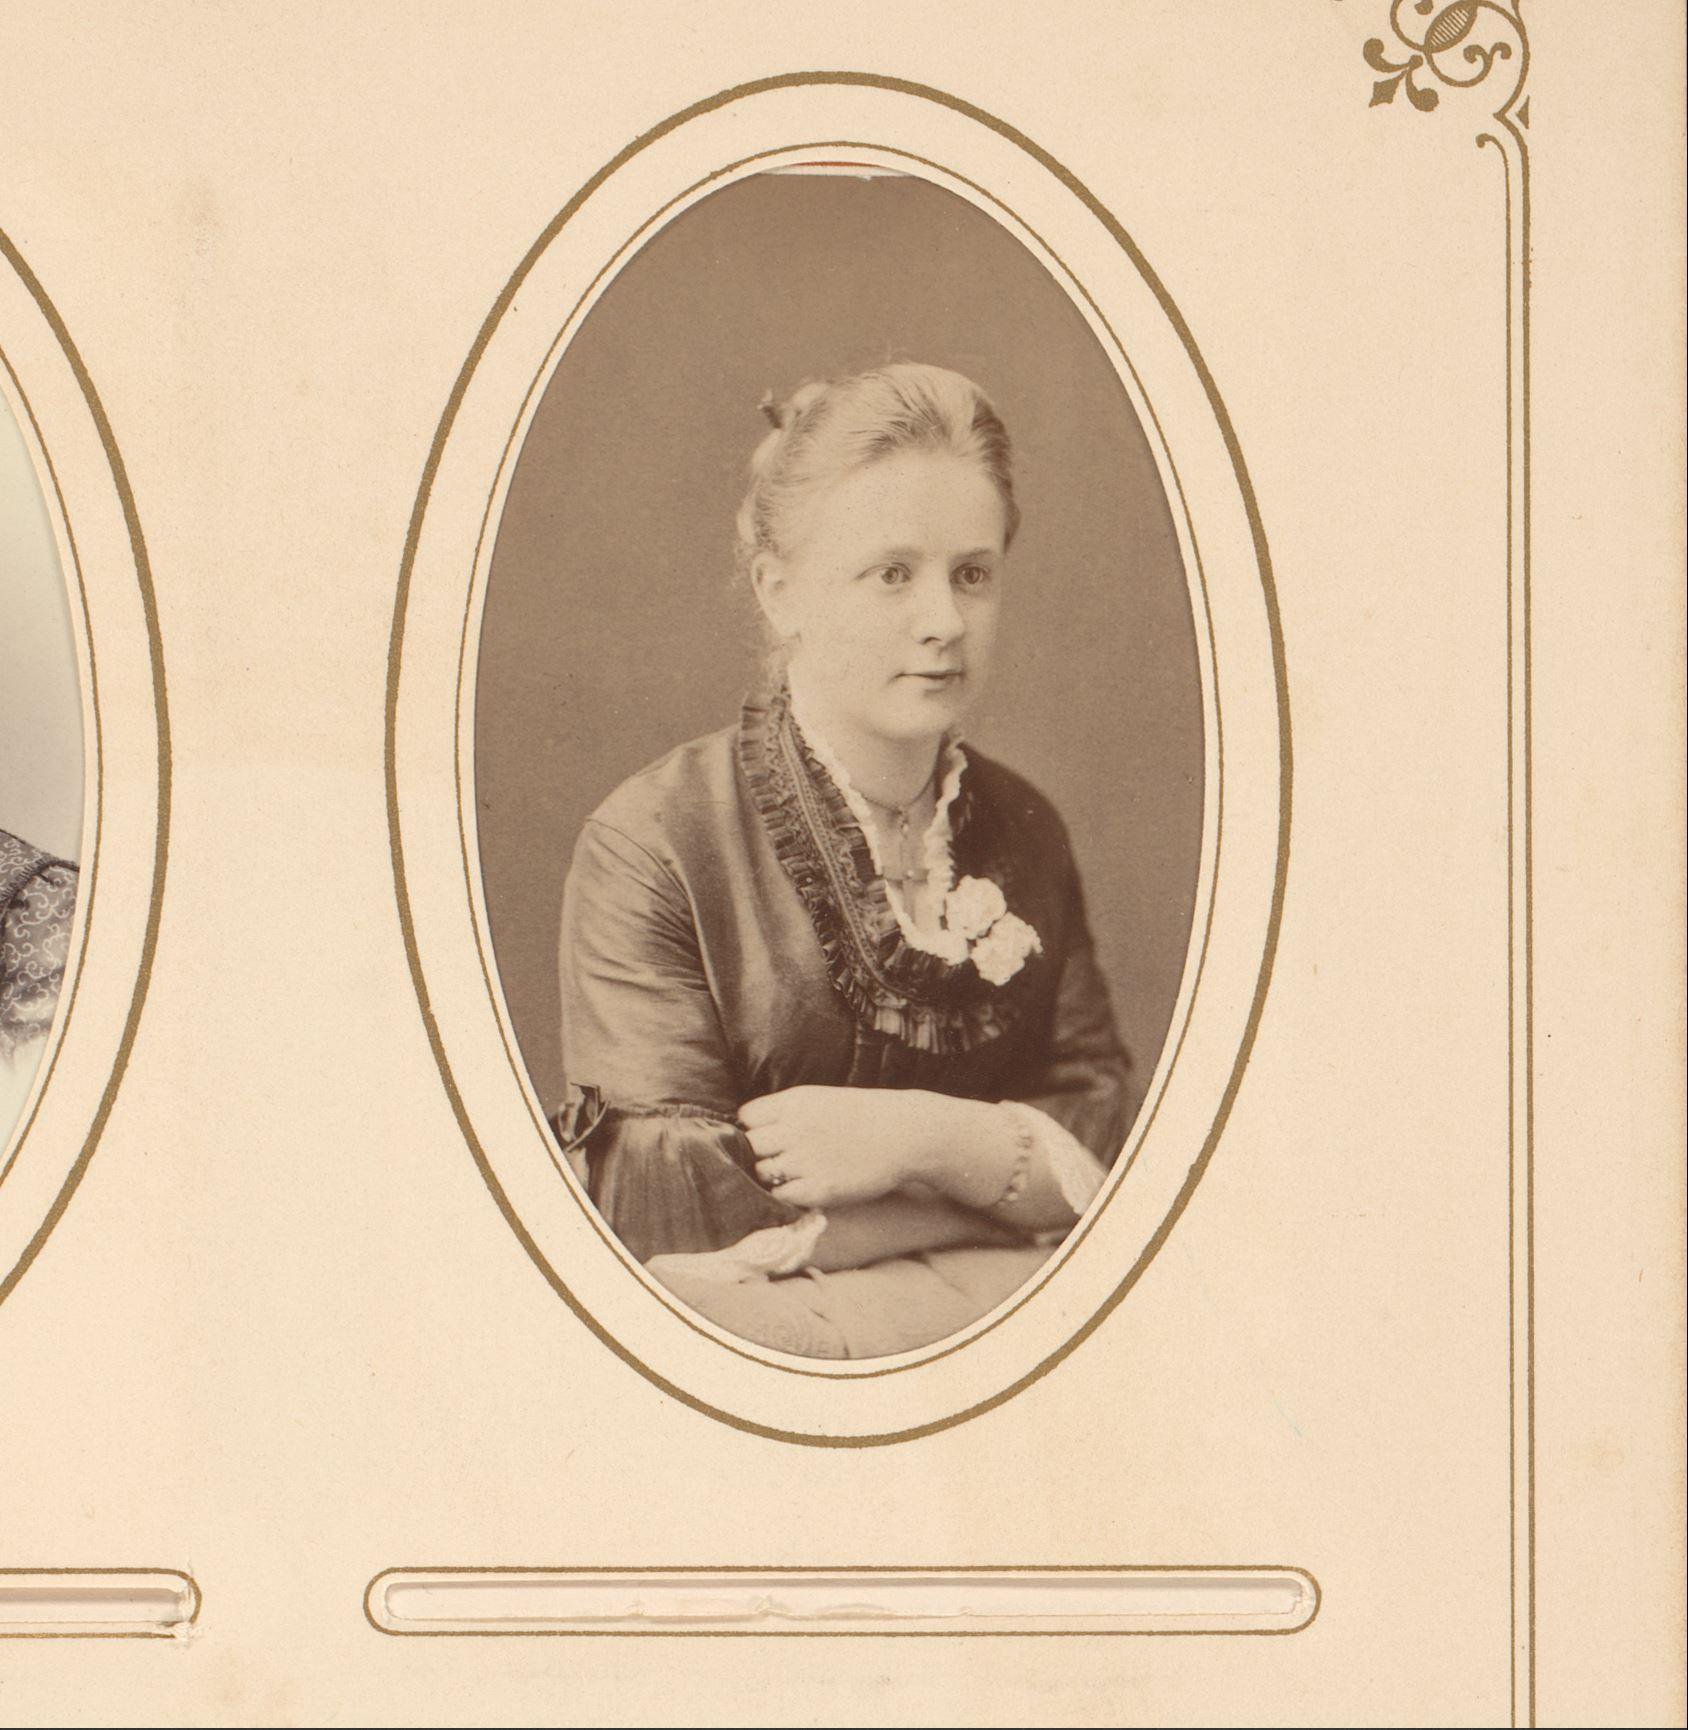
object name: carte de visite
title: Portret van een vrouw, aangeduid als Adolfine Koch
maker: georg rudloff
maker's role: fotograaf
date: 1850-1900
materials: cardboard, photographic support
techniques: albumen print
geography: hannover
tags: historical persons - bb - woman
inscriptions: annotation: ‘Adolfine Koch/ [...]/ Schneiderien’, inscription: ‘PHOTOGRAPHISCHE ANSTALT/ GEORG RUDLOFF/ HANNOVER/ Nicolaistr. 11a/ Hinterhaus neben Odeon./ Die Originalplatte wird für Nachbestellungen aufbewahrt.’